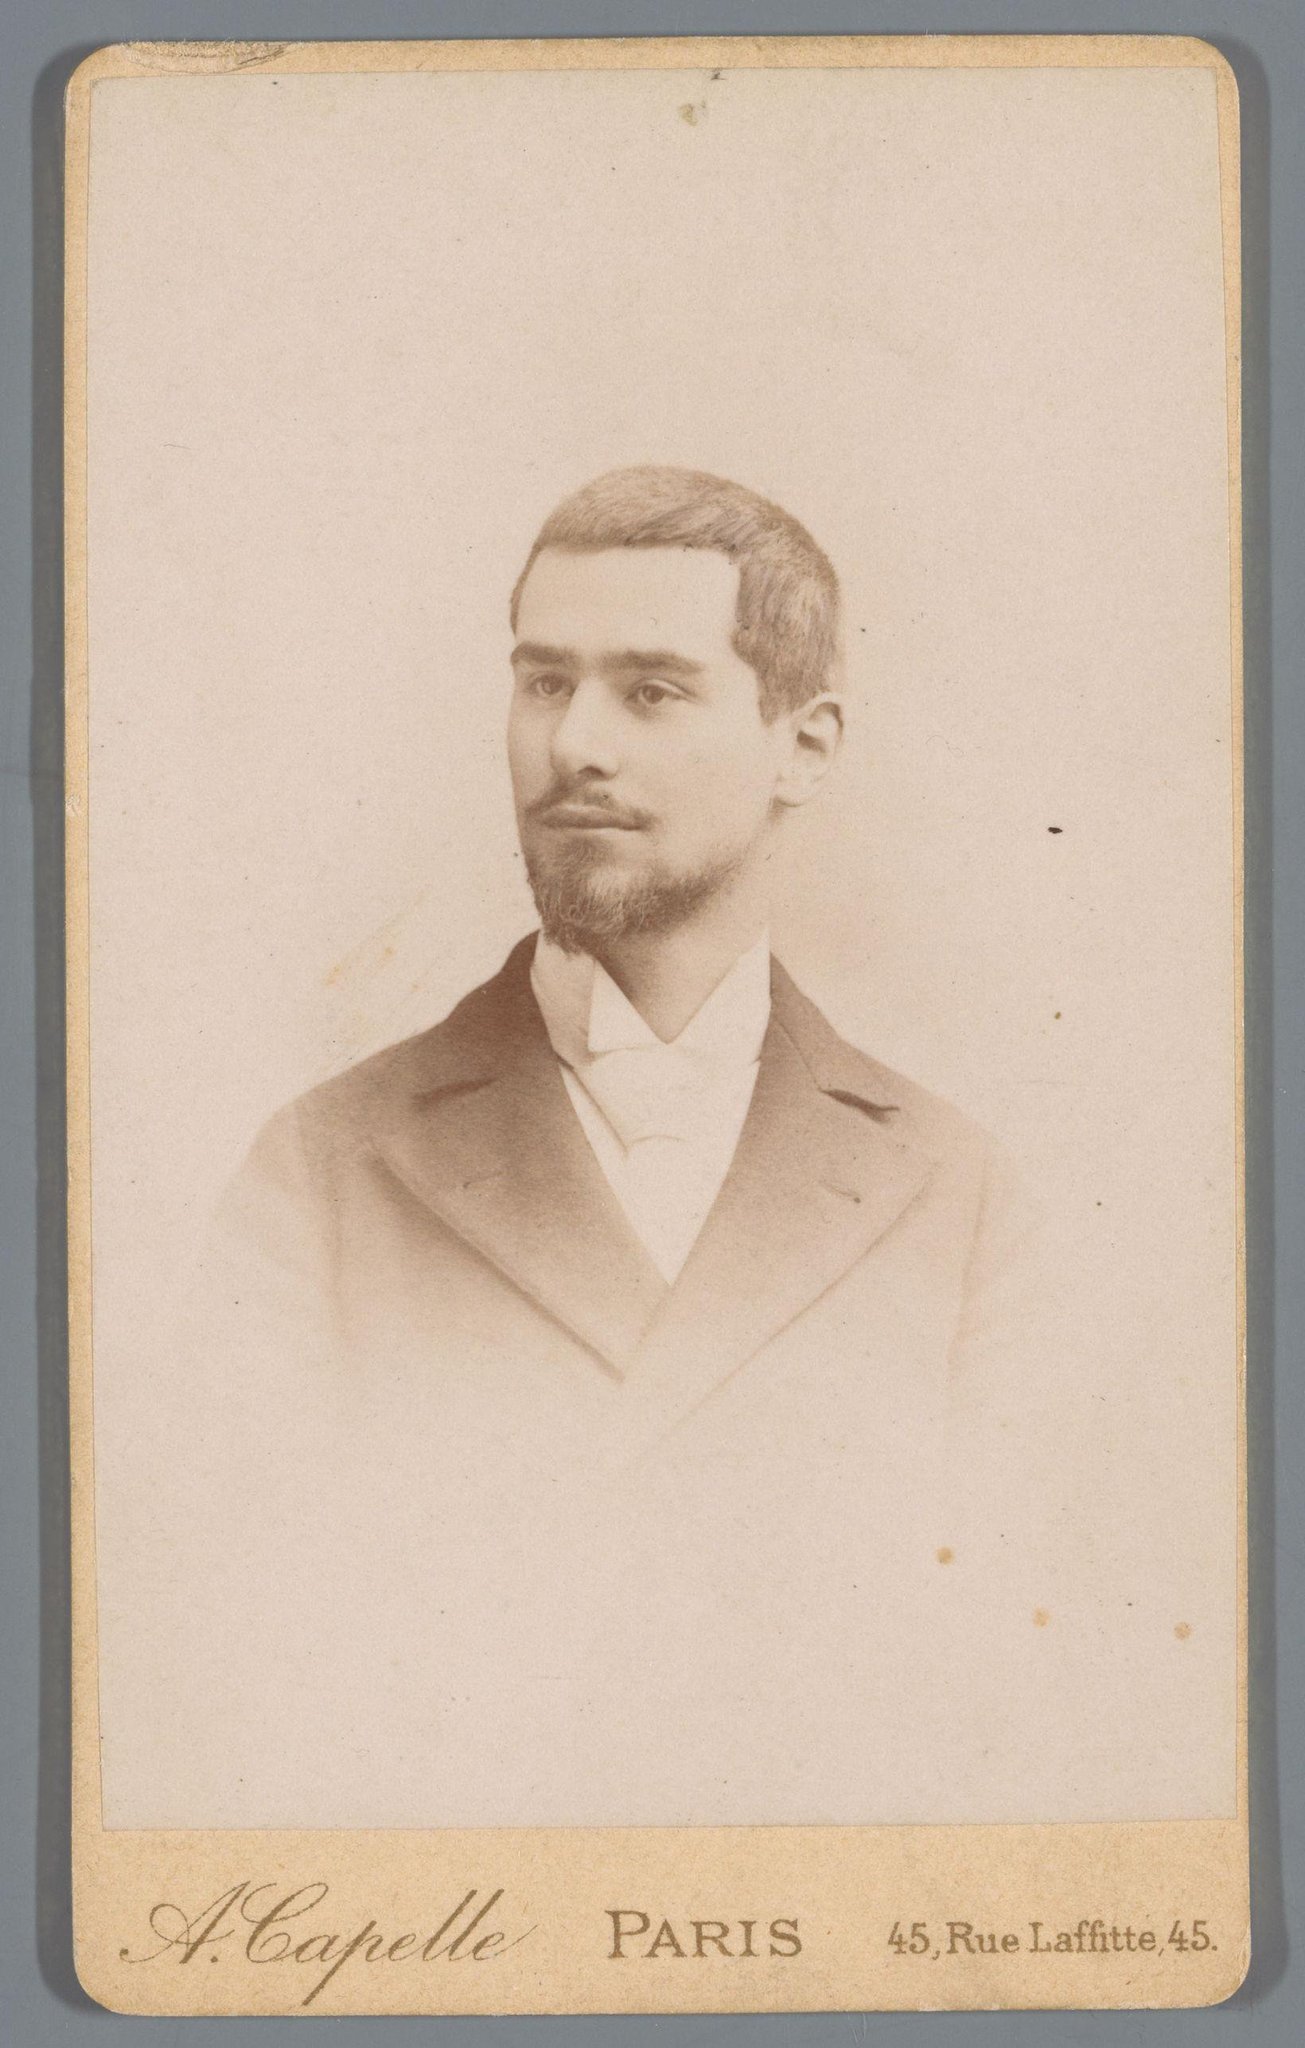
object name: photograph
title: Portret van een onbekende man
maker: albert capelle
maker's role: fotograaf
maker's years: 1854-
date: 1889-1893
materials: cardboard, paper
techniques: albumen print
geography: paris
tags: adult man, historical persons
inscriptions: inscription: ‘Photographie d'Art/ CONTEMPORAINS/ Célébrités Artistiques/ PARIS 1889/ [...]/ALBERT CAPELLE/ 45, Rue Lafitte, 45/ PARIS./ Les Clichés sont Conservés’